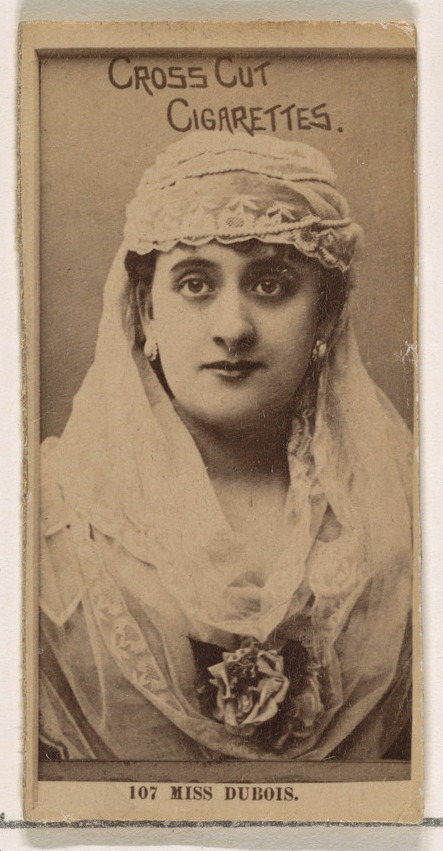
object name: print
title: Card Number 107, Mrs. Dubois, from the Actors and Actresses series (N145-2) issued by Duke Sons & Co. to promote Cross Cut Cigarettes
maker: w. duke, sons & co.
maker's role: publisher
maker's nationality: american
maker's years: 1870-1920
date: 1880-1889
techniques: albumen silver print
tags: portraits,women,actresses